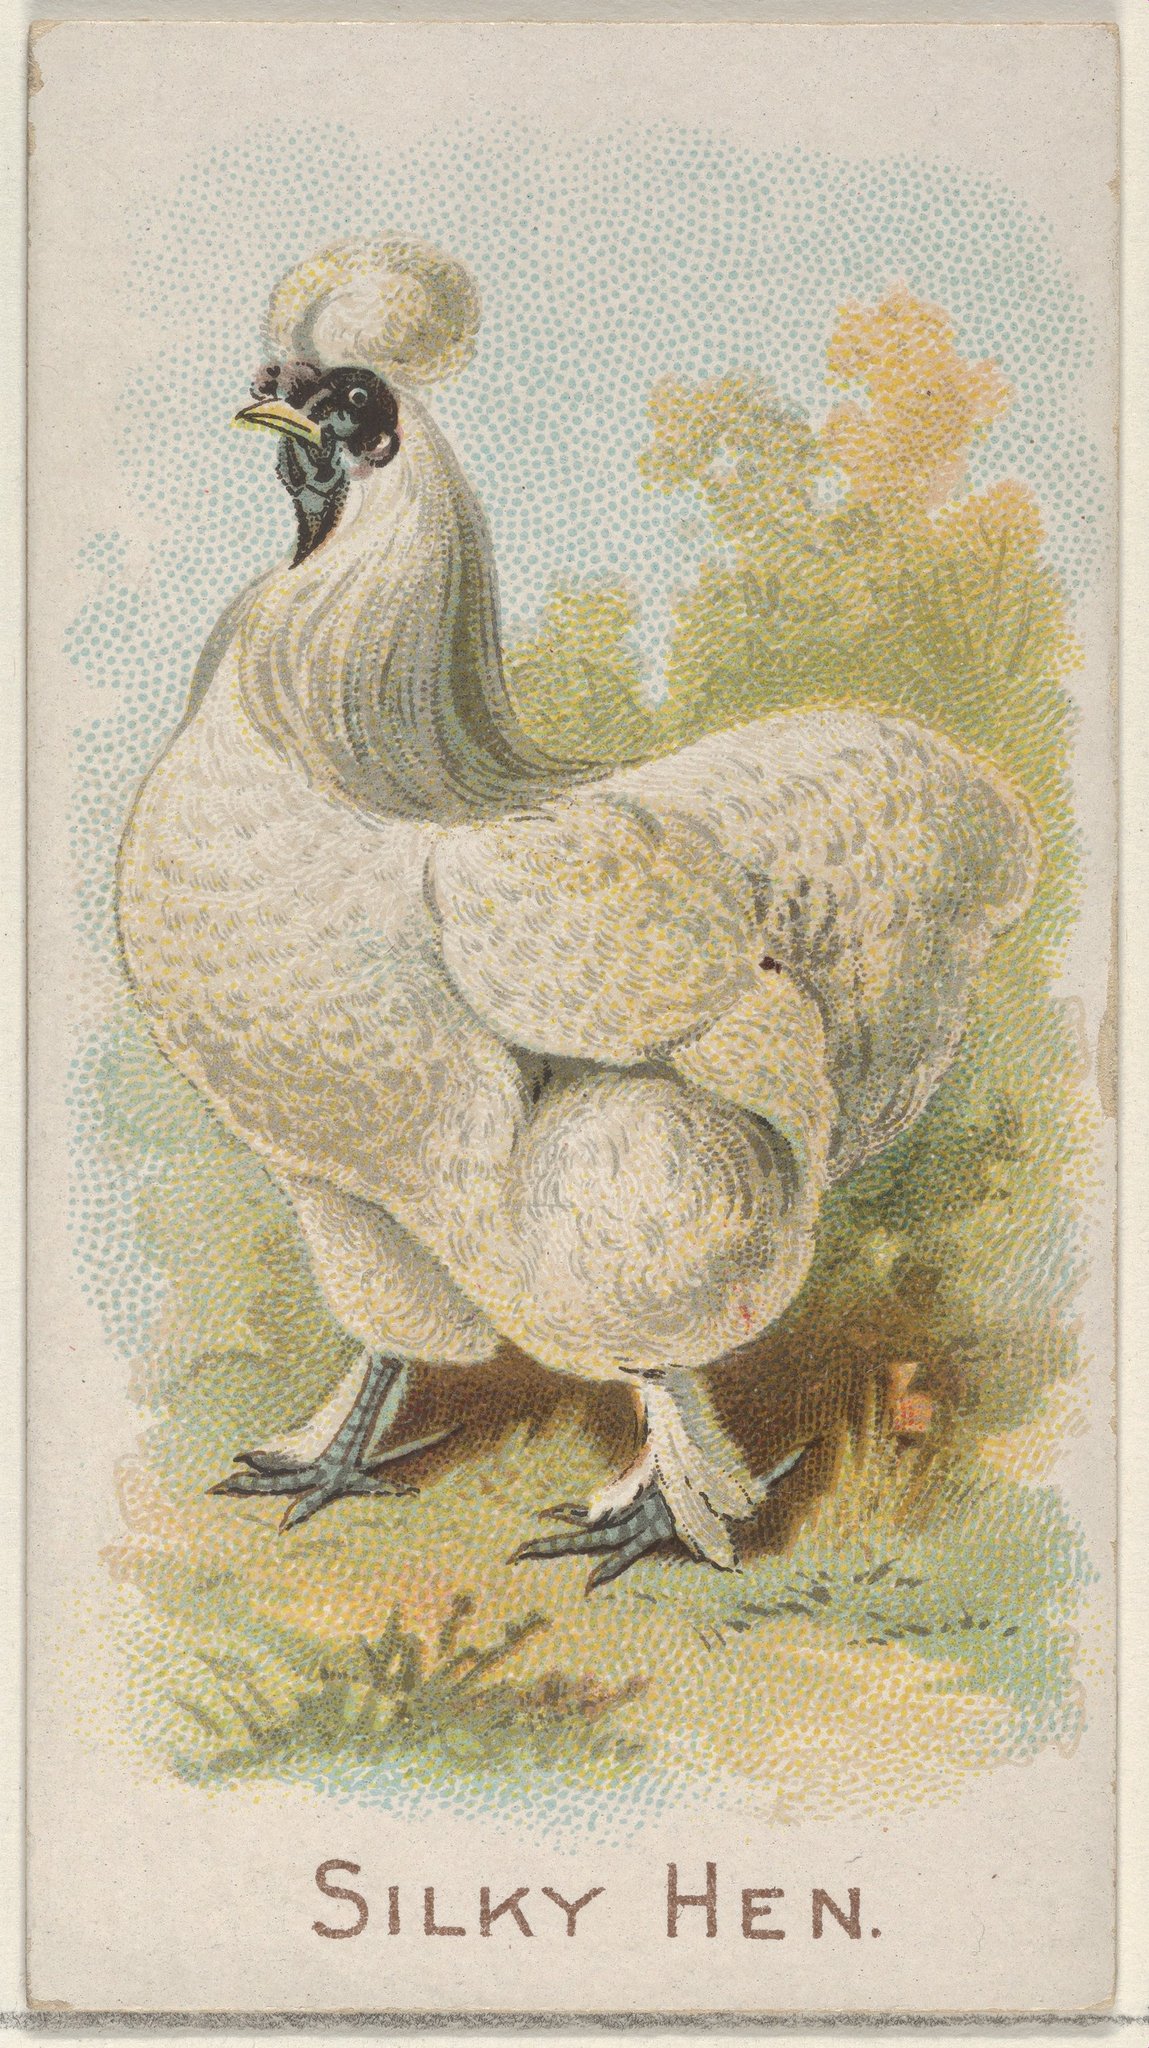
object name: print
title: Silky Hen, from the Prize and Game Chickens series (N20) for Allen & Ginter Cigarettes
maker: allen & ginter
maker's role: publisher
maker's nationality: american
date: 1891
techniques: color lithograph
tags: chickens